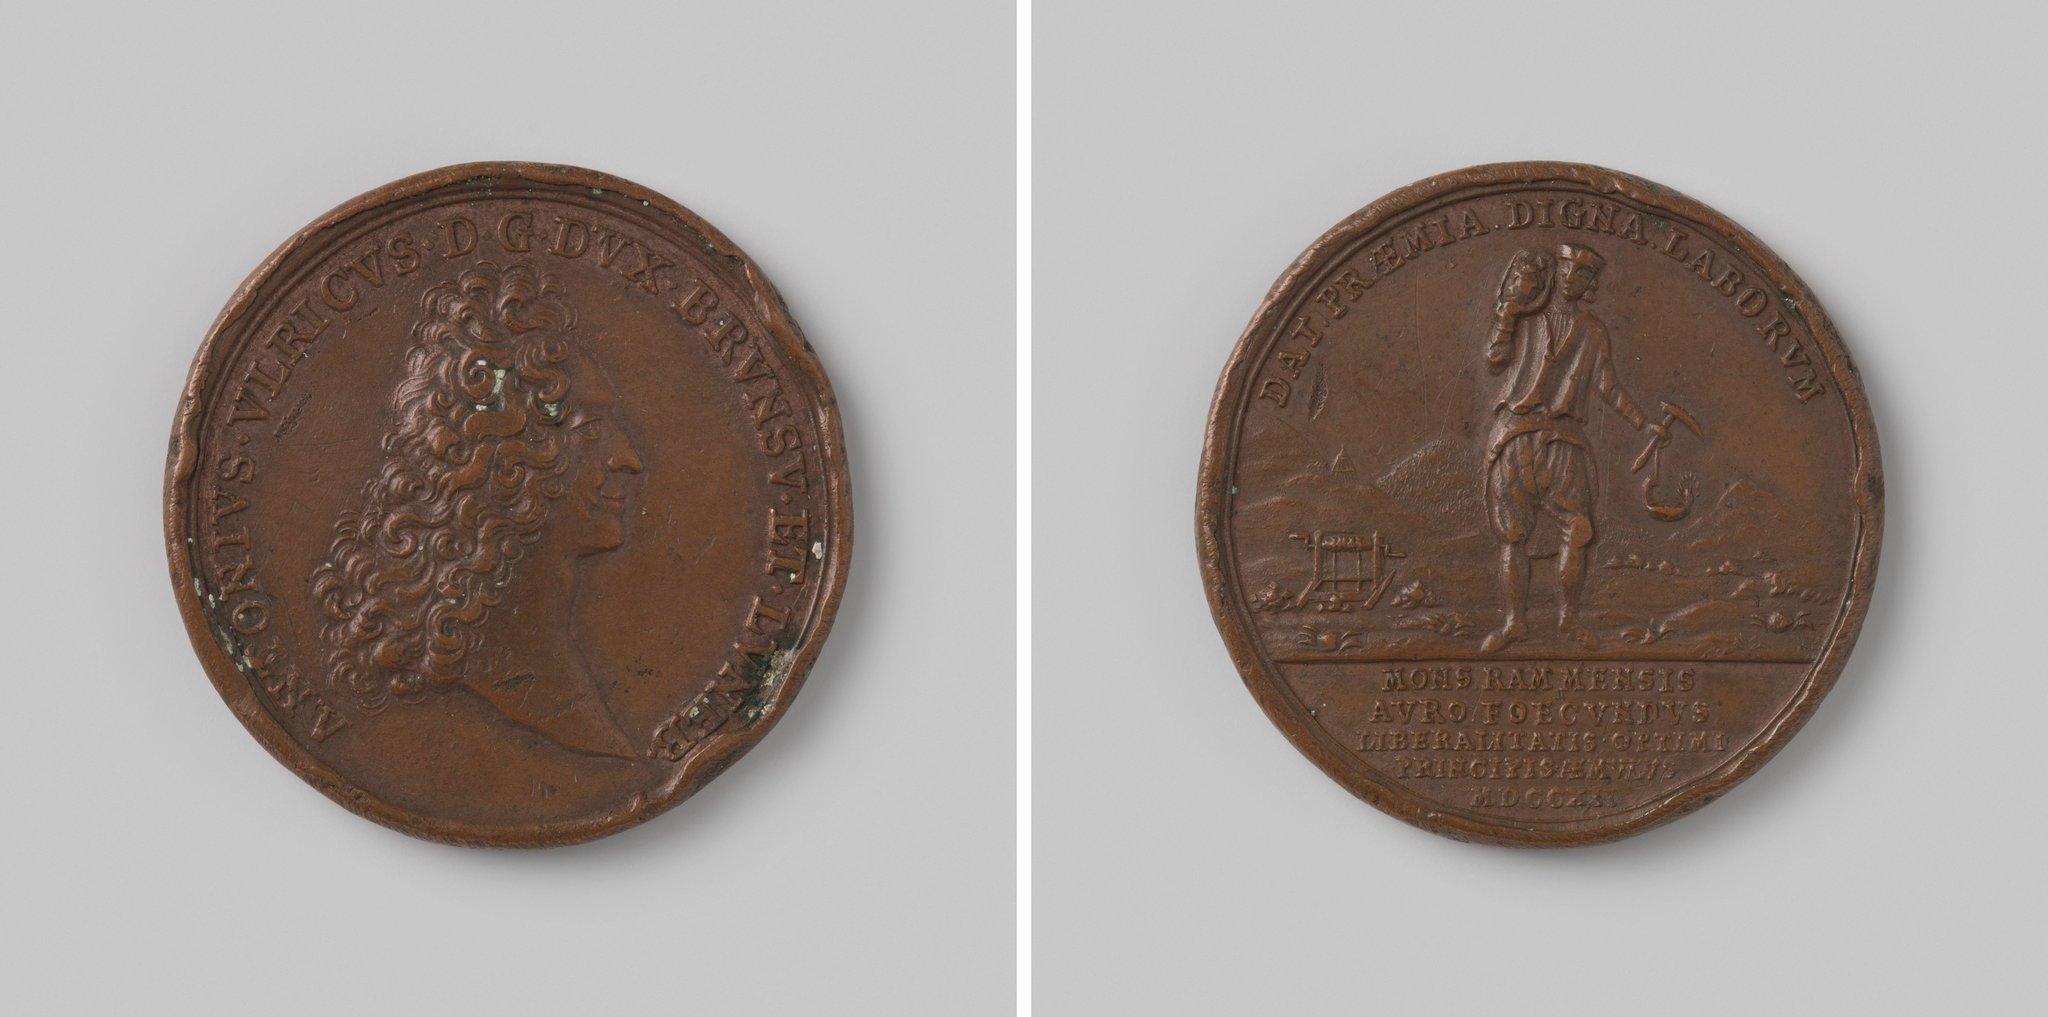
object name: history medal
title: Goudvondst in Brunswijk-Wolfenbüttel onder hertog Anton Ulrich 1712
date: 1712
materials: copper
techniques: striking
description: Koperen penning, op de voorzijde het portret van hertog Anton Ulrich naar rechts met omschrift, op de keerzijde een goudzoeker met olielamp in een landschap, met omschrift en afsnedetekst.